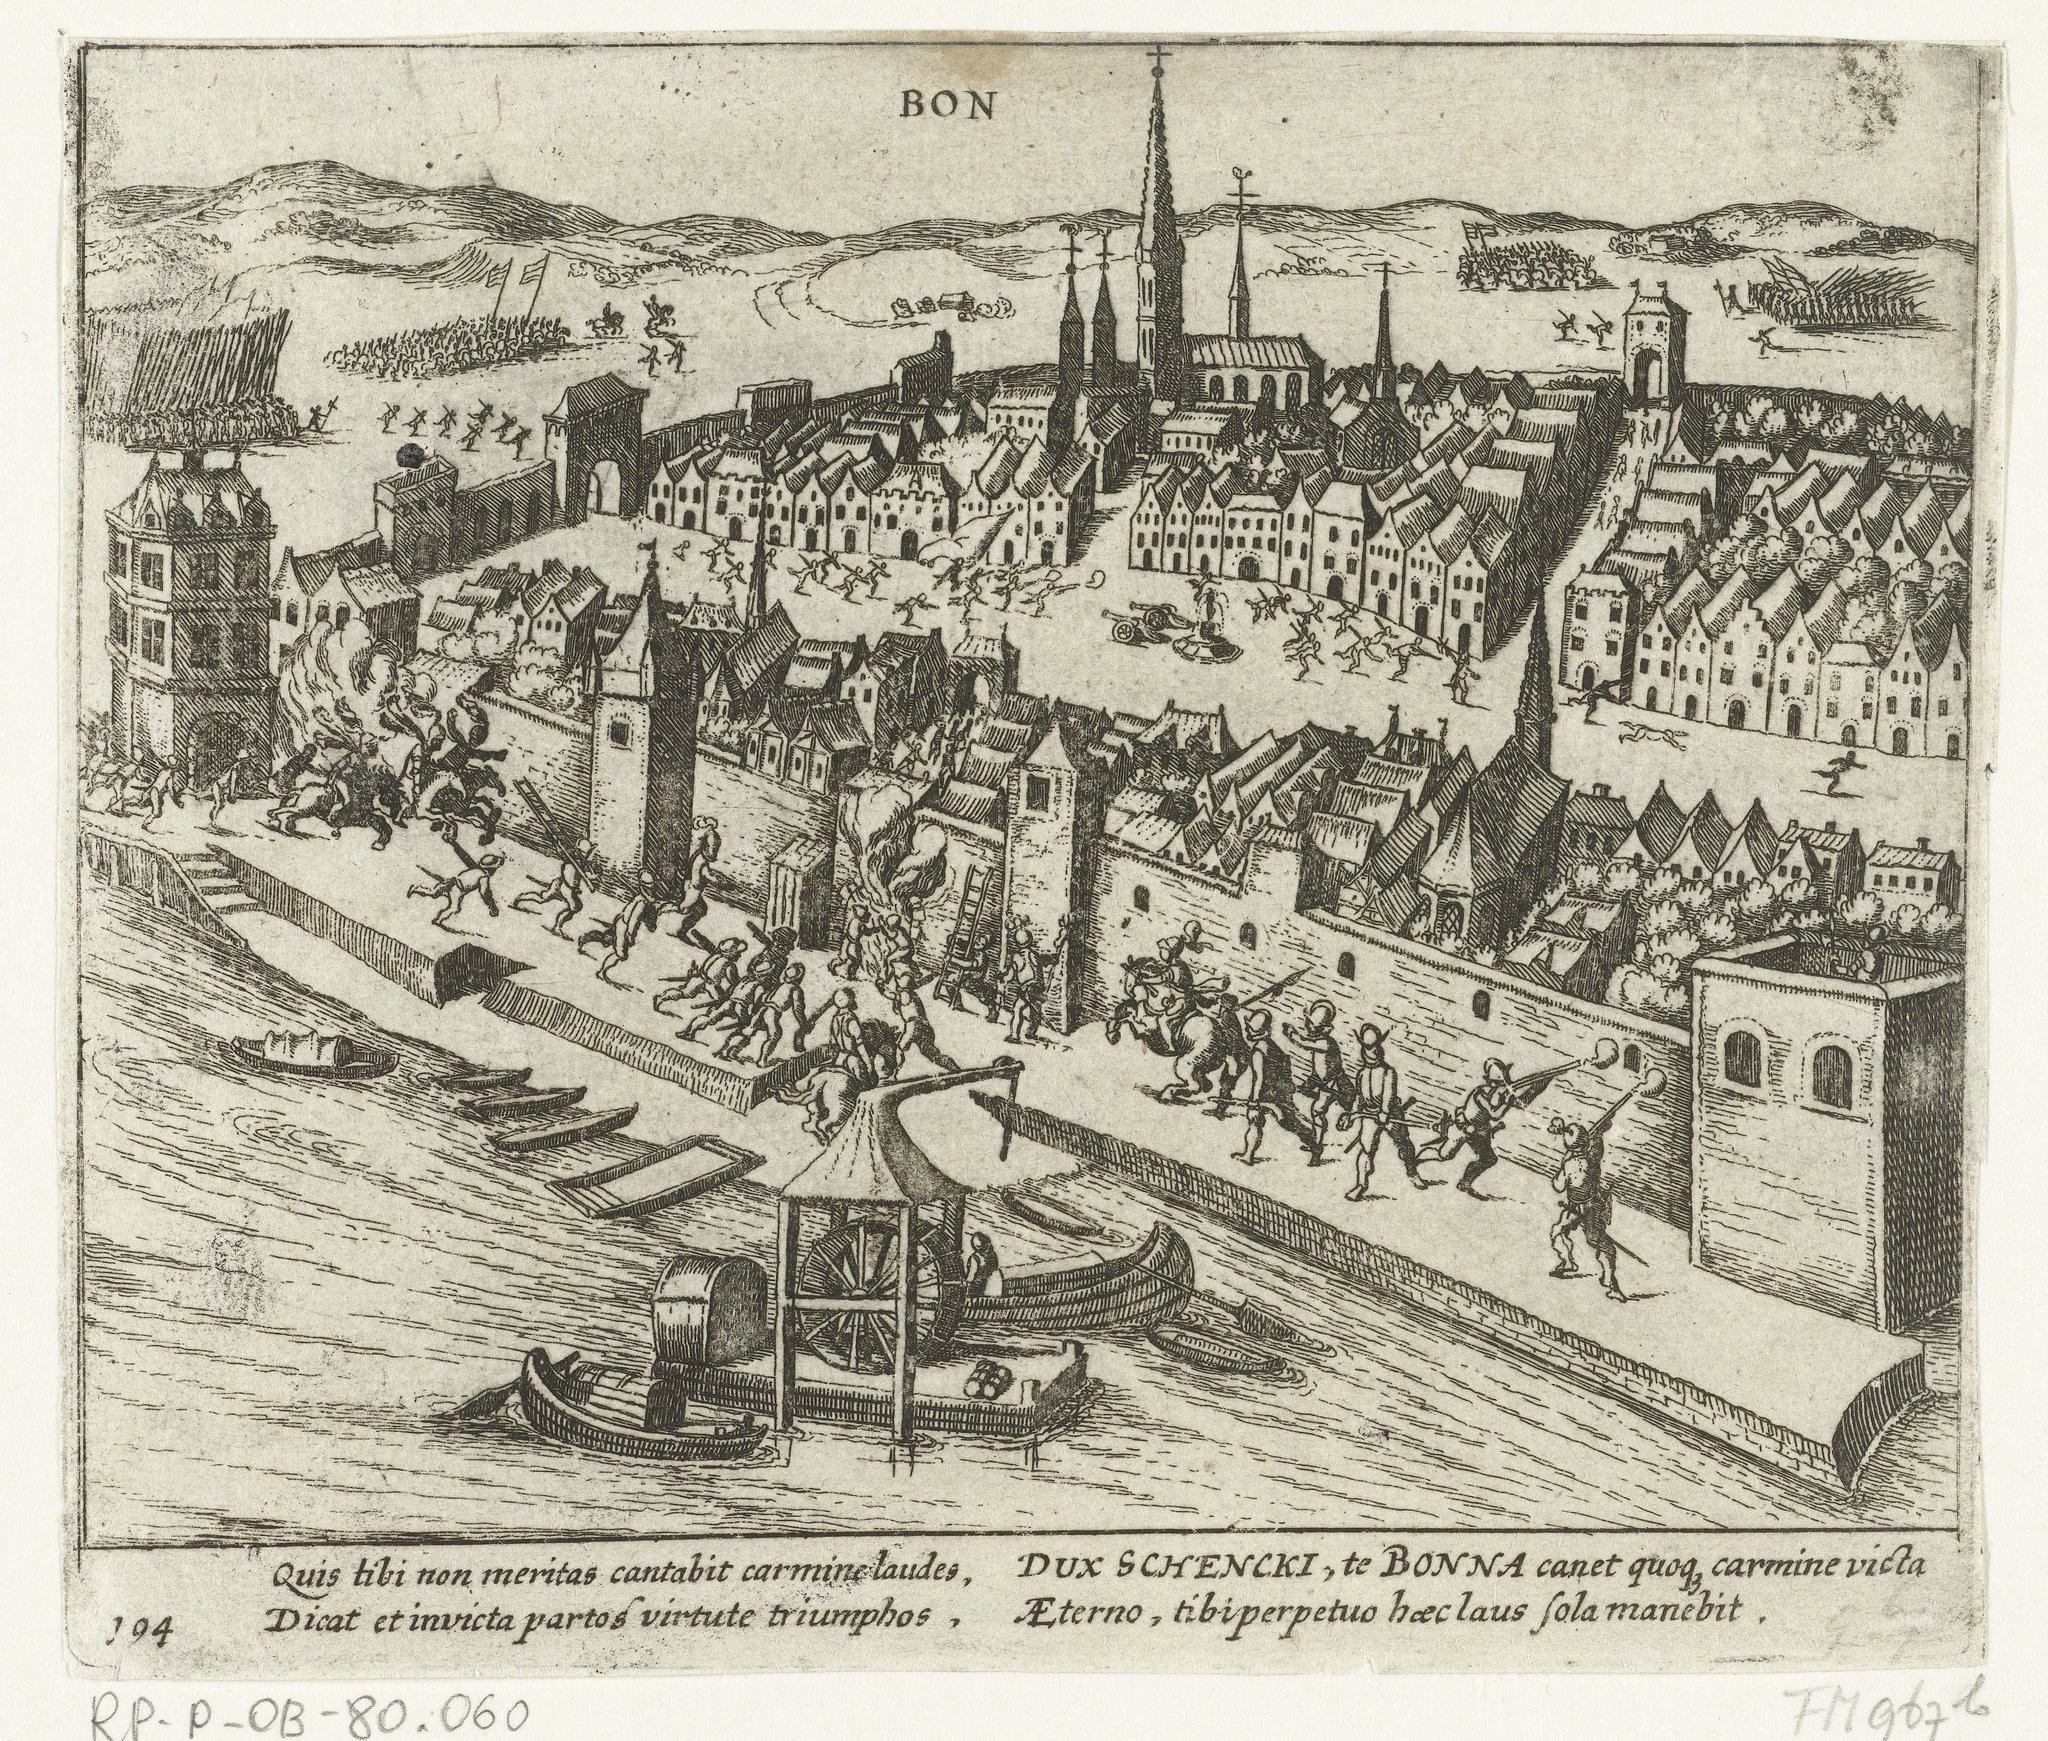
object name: print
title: Bonn door Schenck voor Truchsess gewonnen, 1587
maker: Anonymous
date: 1613-1615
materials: paper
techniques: etching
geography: northern netherlands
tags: nijmegen, capture of city (after the siege)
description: Bonn door Schenck voor Truchsess gewonnen, 23 december 1587. Episode uit de Keulse Oorlog. Met onderschrift van 4 regels in het Latijn. Genummerd 194. Onbedrukt op achterzijde.